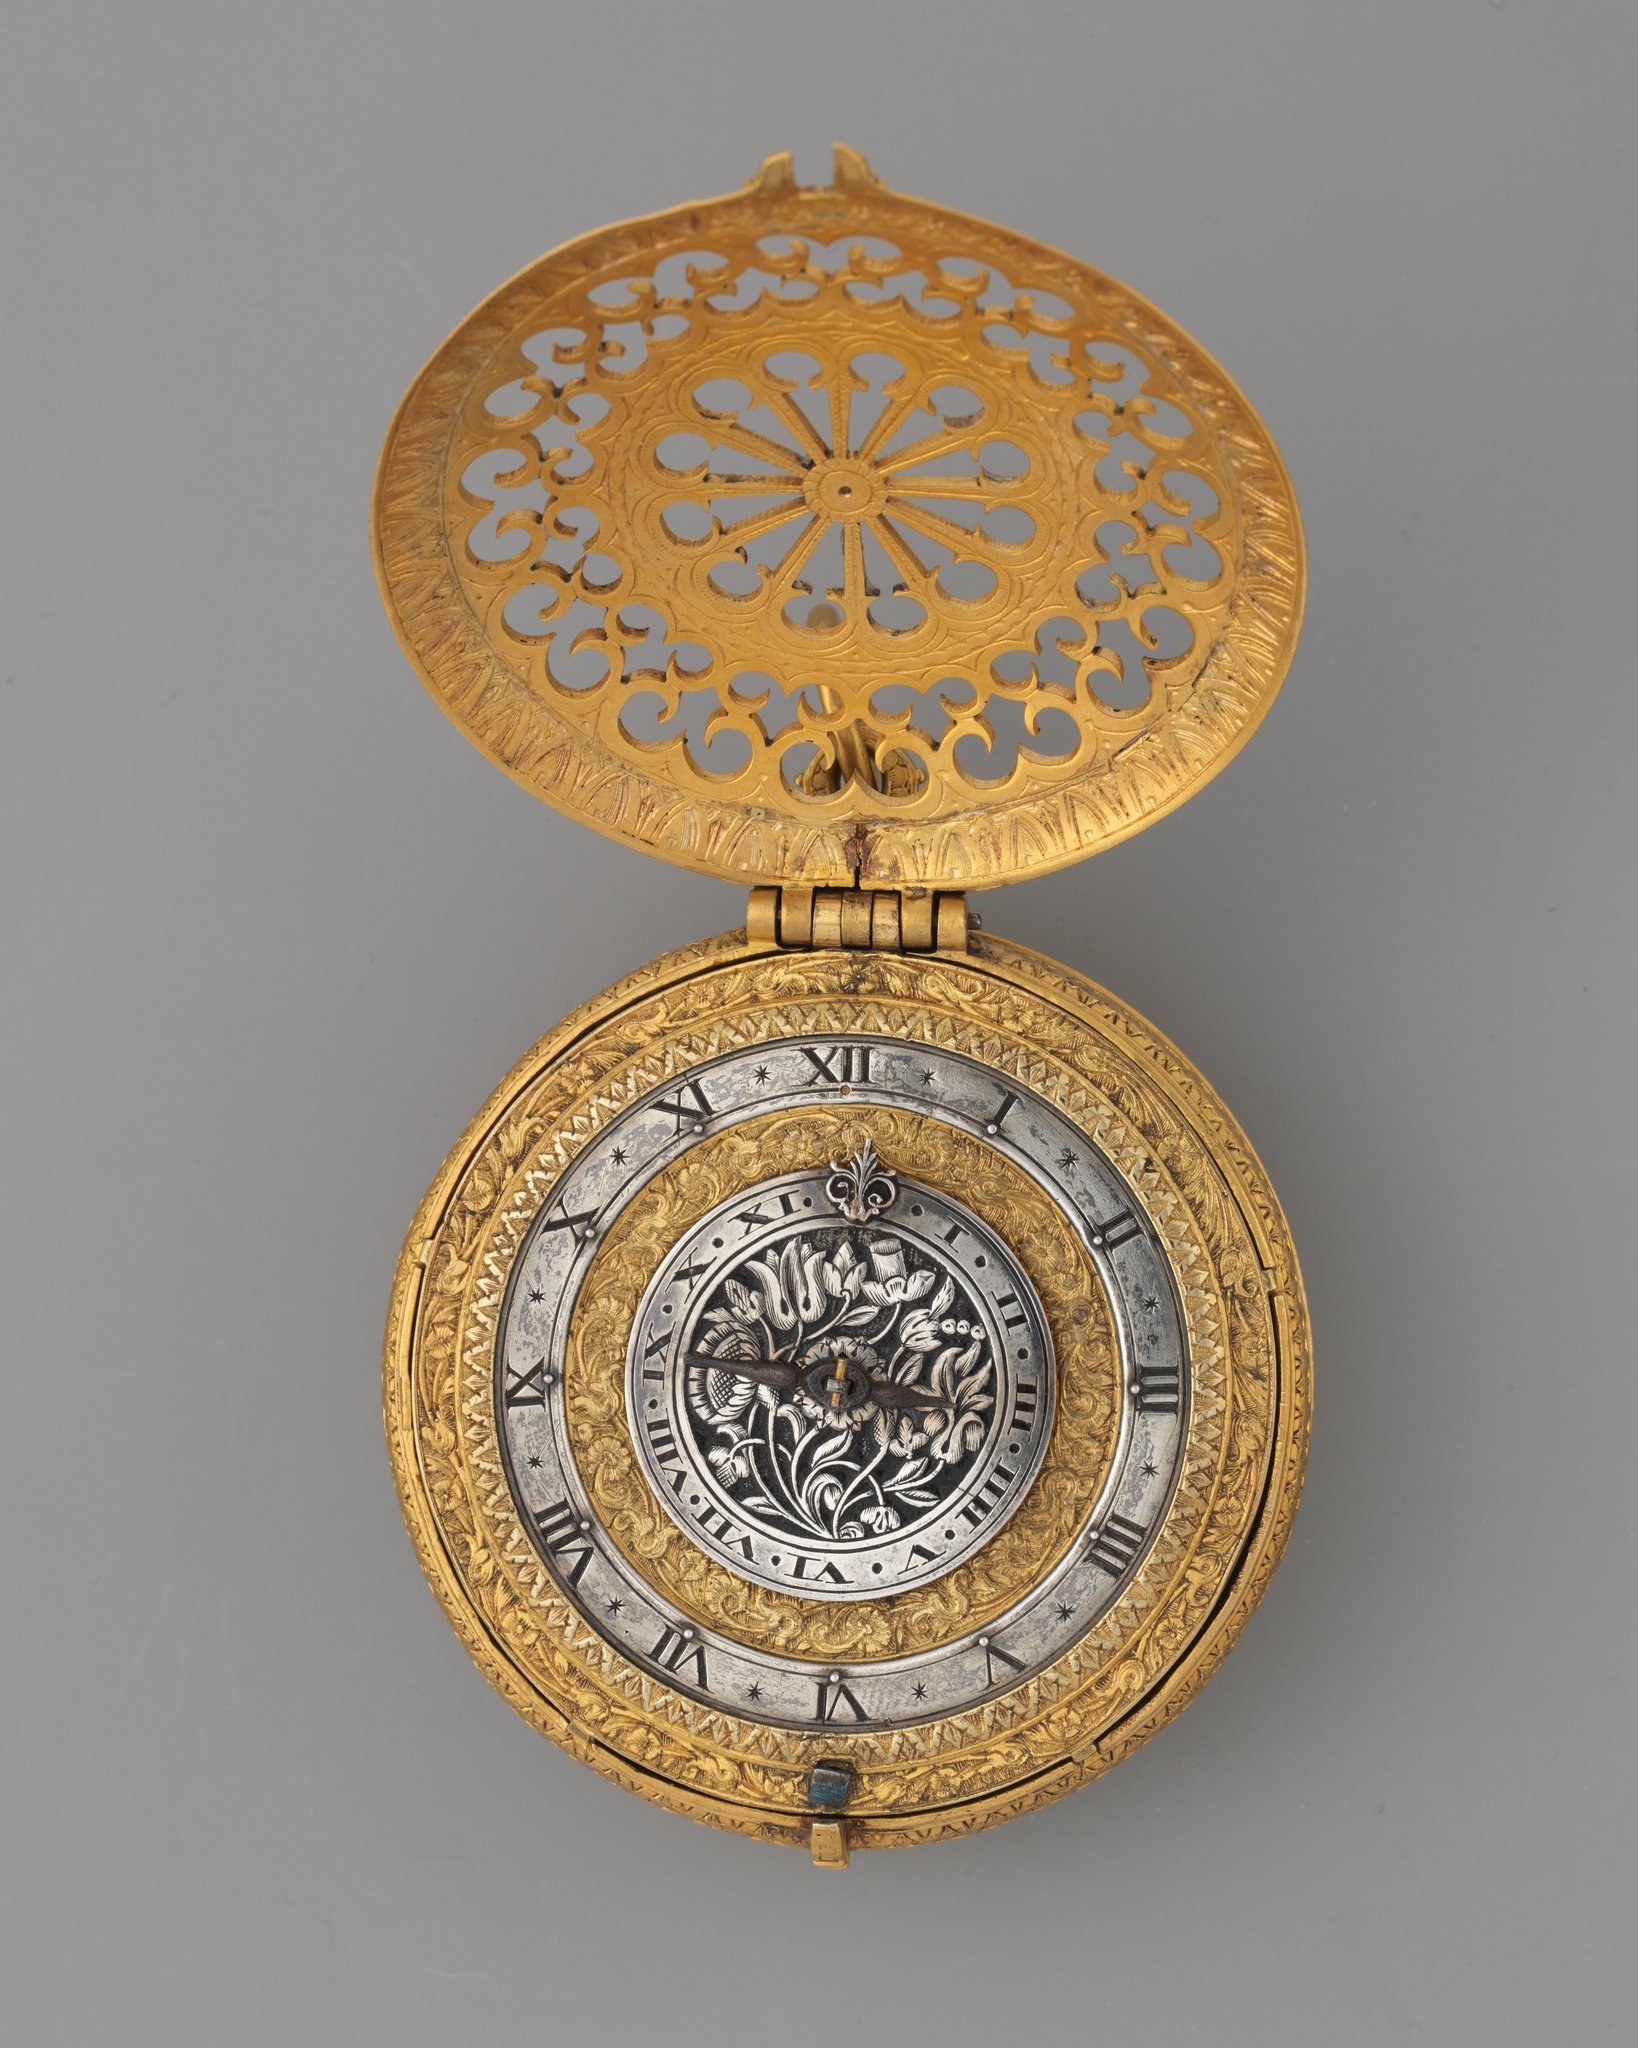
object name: alarm watch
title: Watch with alarm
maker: nicholas vallin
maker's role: maker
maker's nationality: flemish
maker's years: 1503-1603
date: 1600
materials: gilt brass, iron